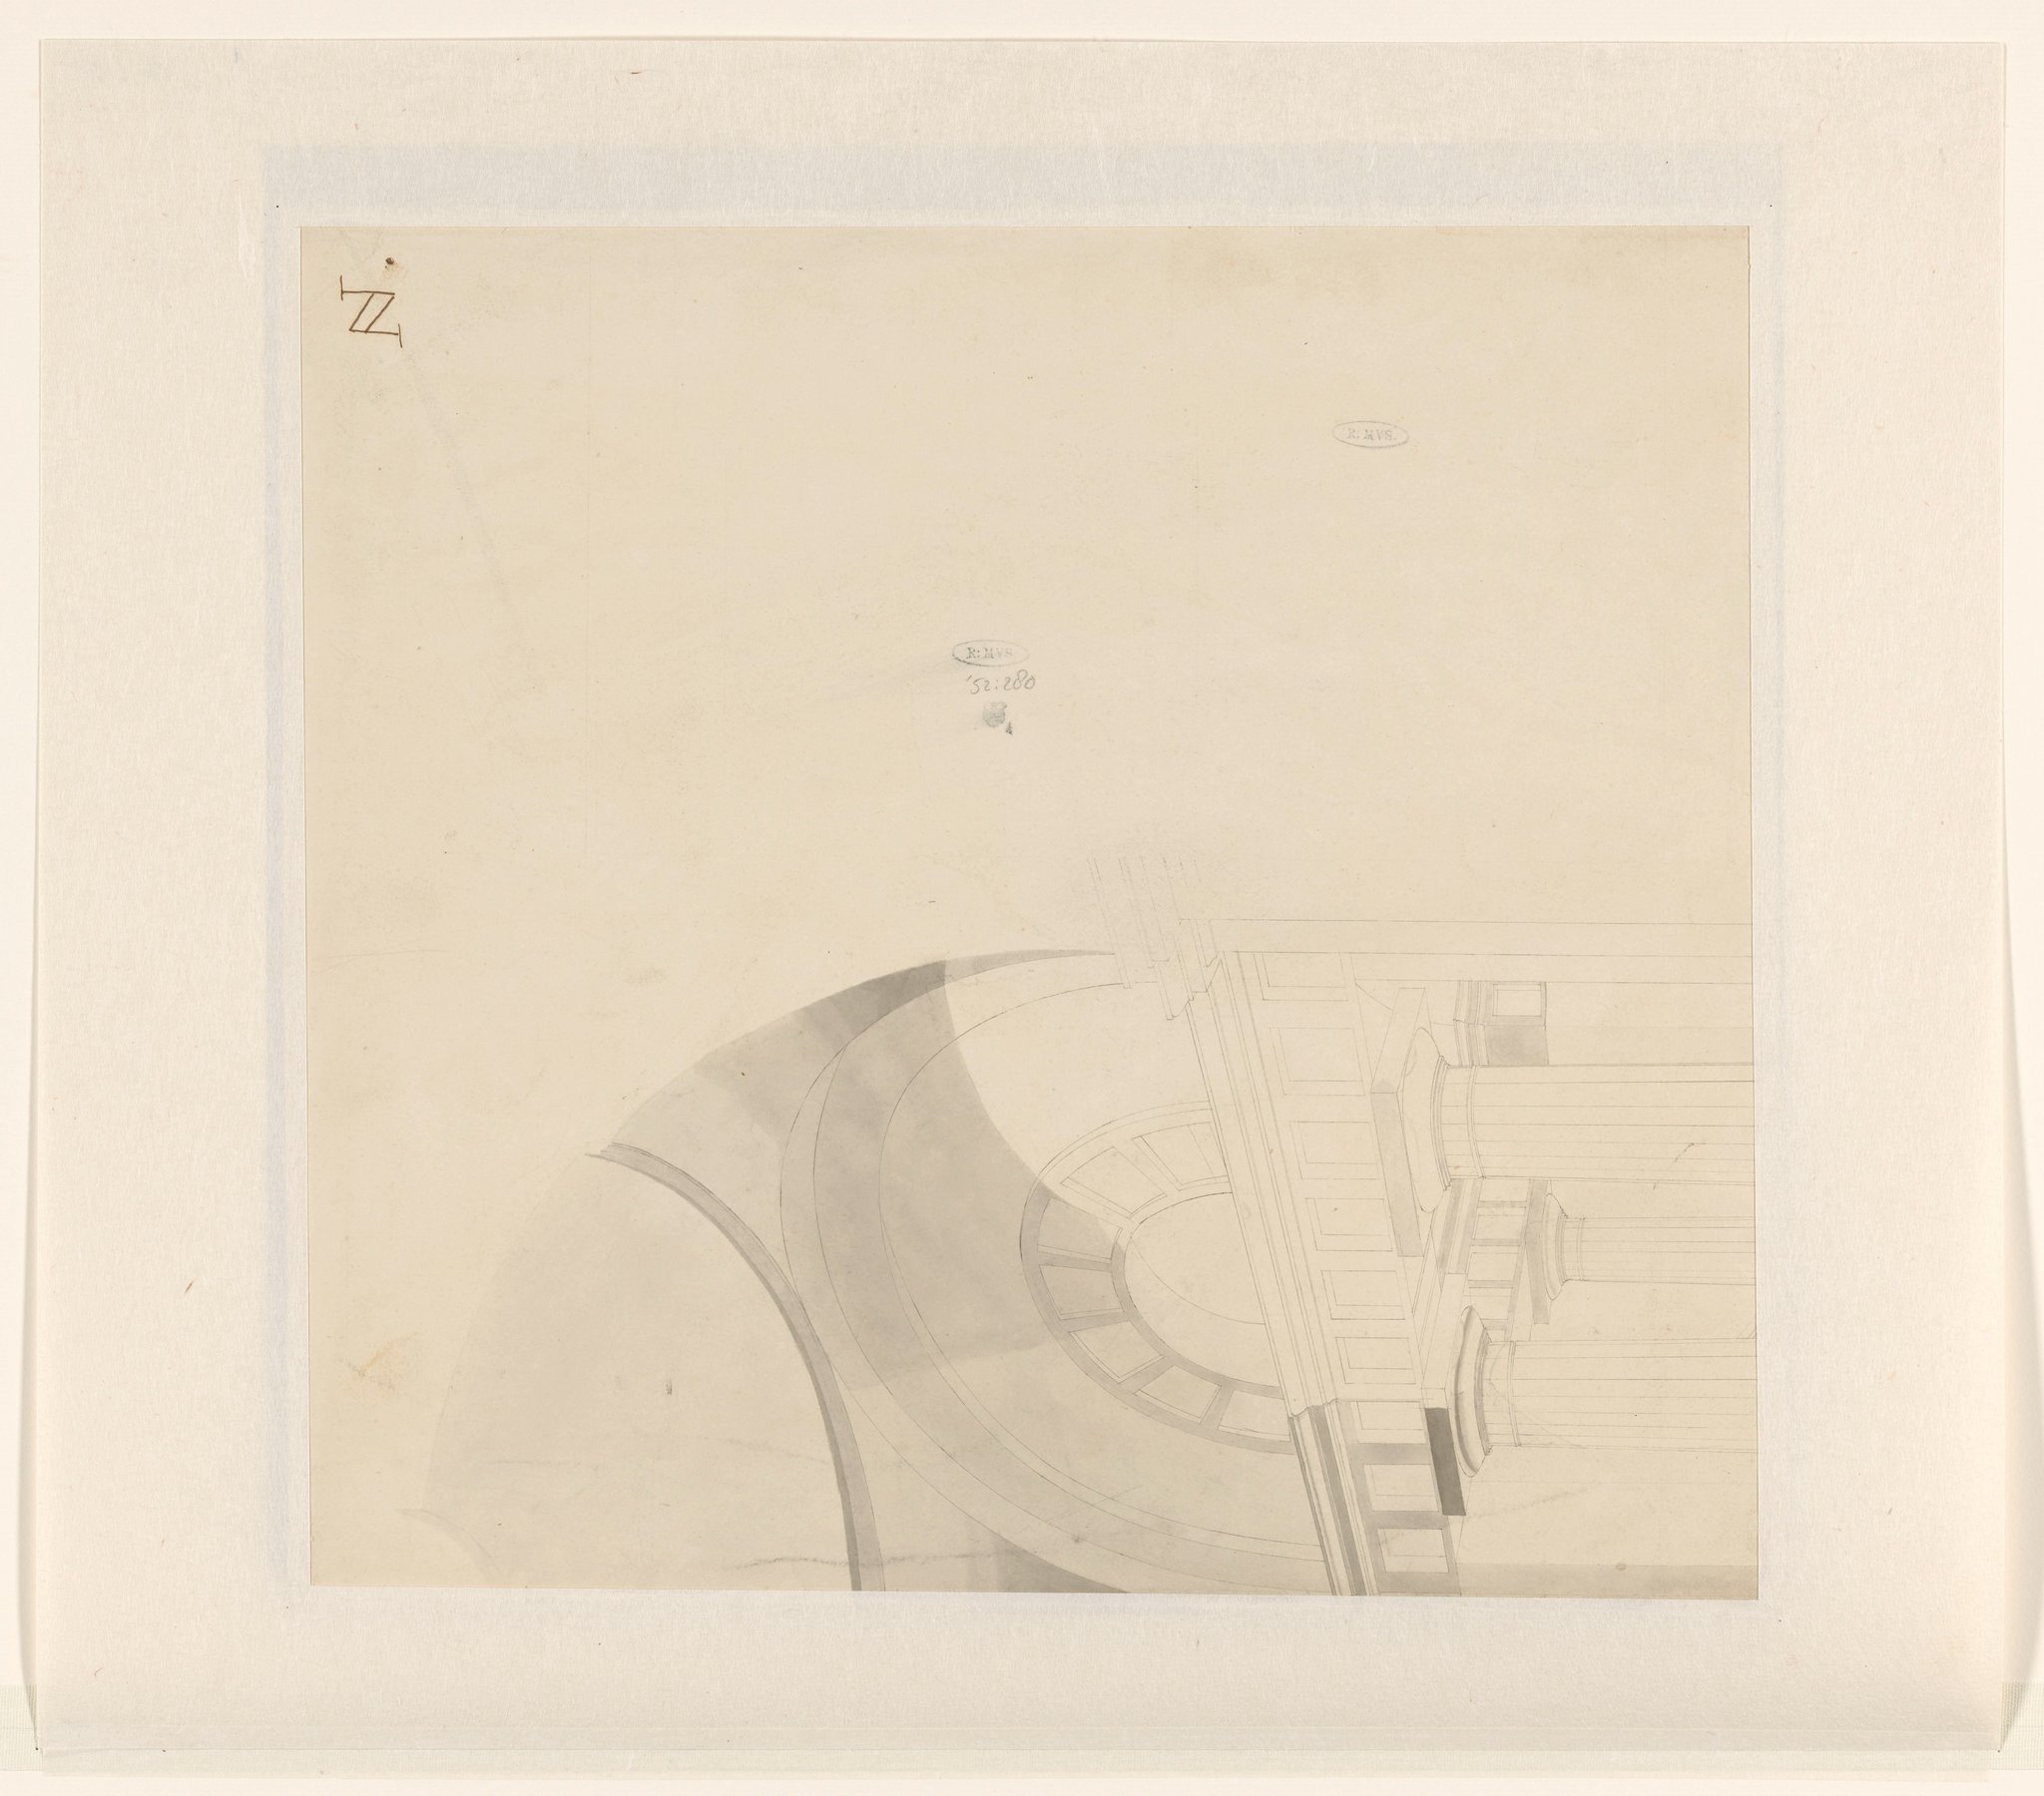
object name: drawing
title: Architectuurstudie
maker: julius jacobus van de sande bakhuyzen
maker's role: draughtsman, painter, print maker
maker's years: 1835-1925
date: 1845-1925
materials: paper, pencil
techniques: brush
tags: architectural detail